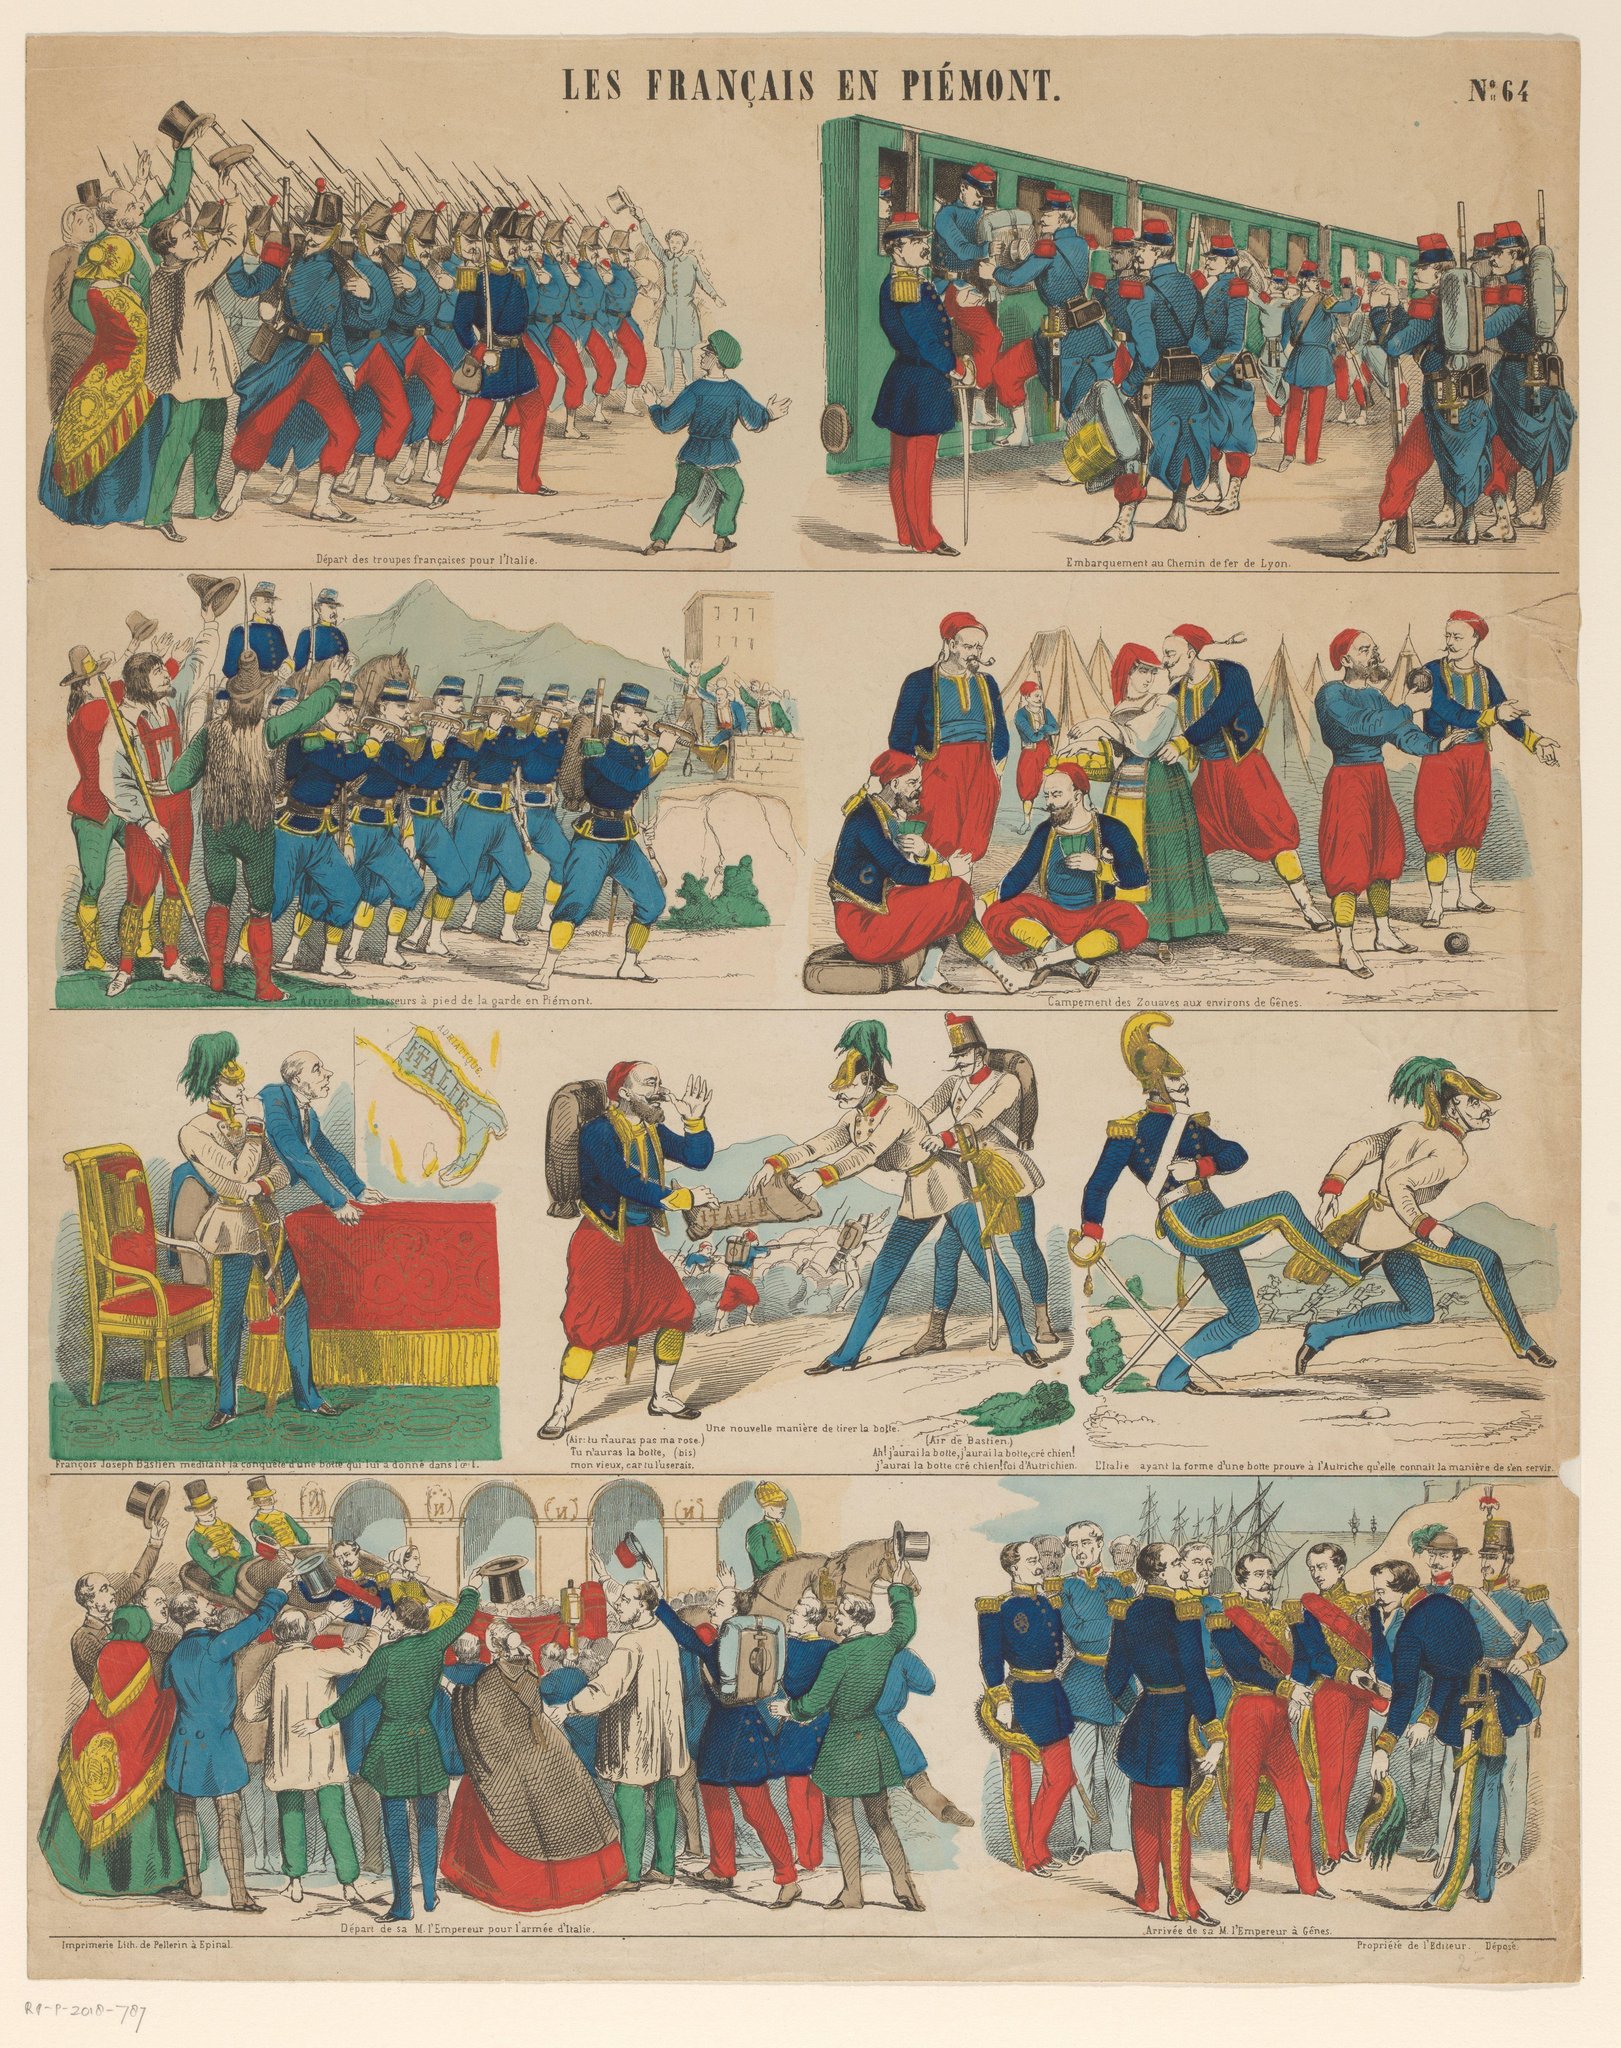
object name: print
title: De Fransen in Piëmont, 1859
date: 1859-1860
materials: paper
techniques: colour, lithograph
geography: epinal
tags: paris, london, napoleon iii (keizer der fransen), troop movements, transportation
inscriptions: collector's mark: Lugt 2228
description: Blad met negen voorstellingen uit Tweede Italiaanse Onafhankelijkheidsoorlog (ook bekend als de Frans-Oostenrijkse Oorlog) in 1859, waarin het Franse leger de Oostenrijkers verjoeg uit Piëmont. Enkele scènes met Franse Zoeaven. In de laatste scène bezoekt keizer Napoleon III Genua. Onder elke afbeelding een onderschrift. Genummerd rechtsboven: No. 64.